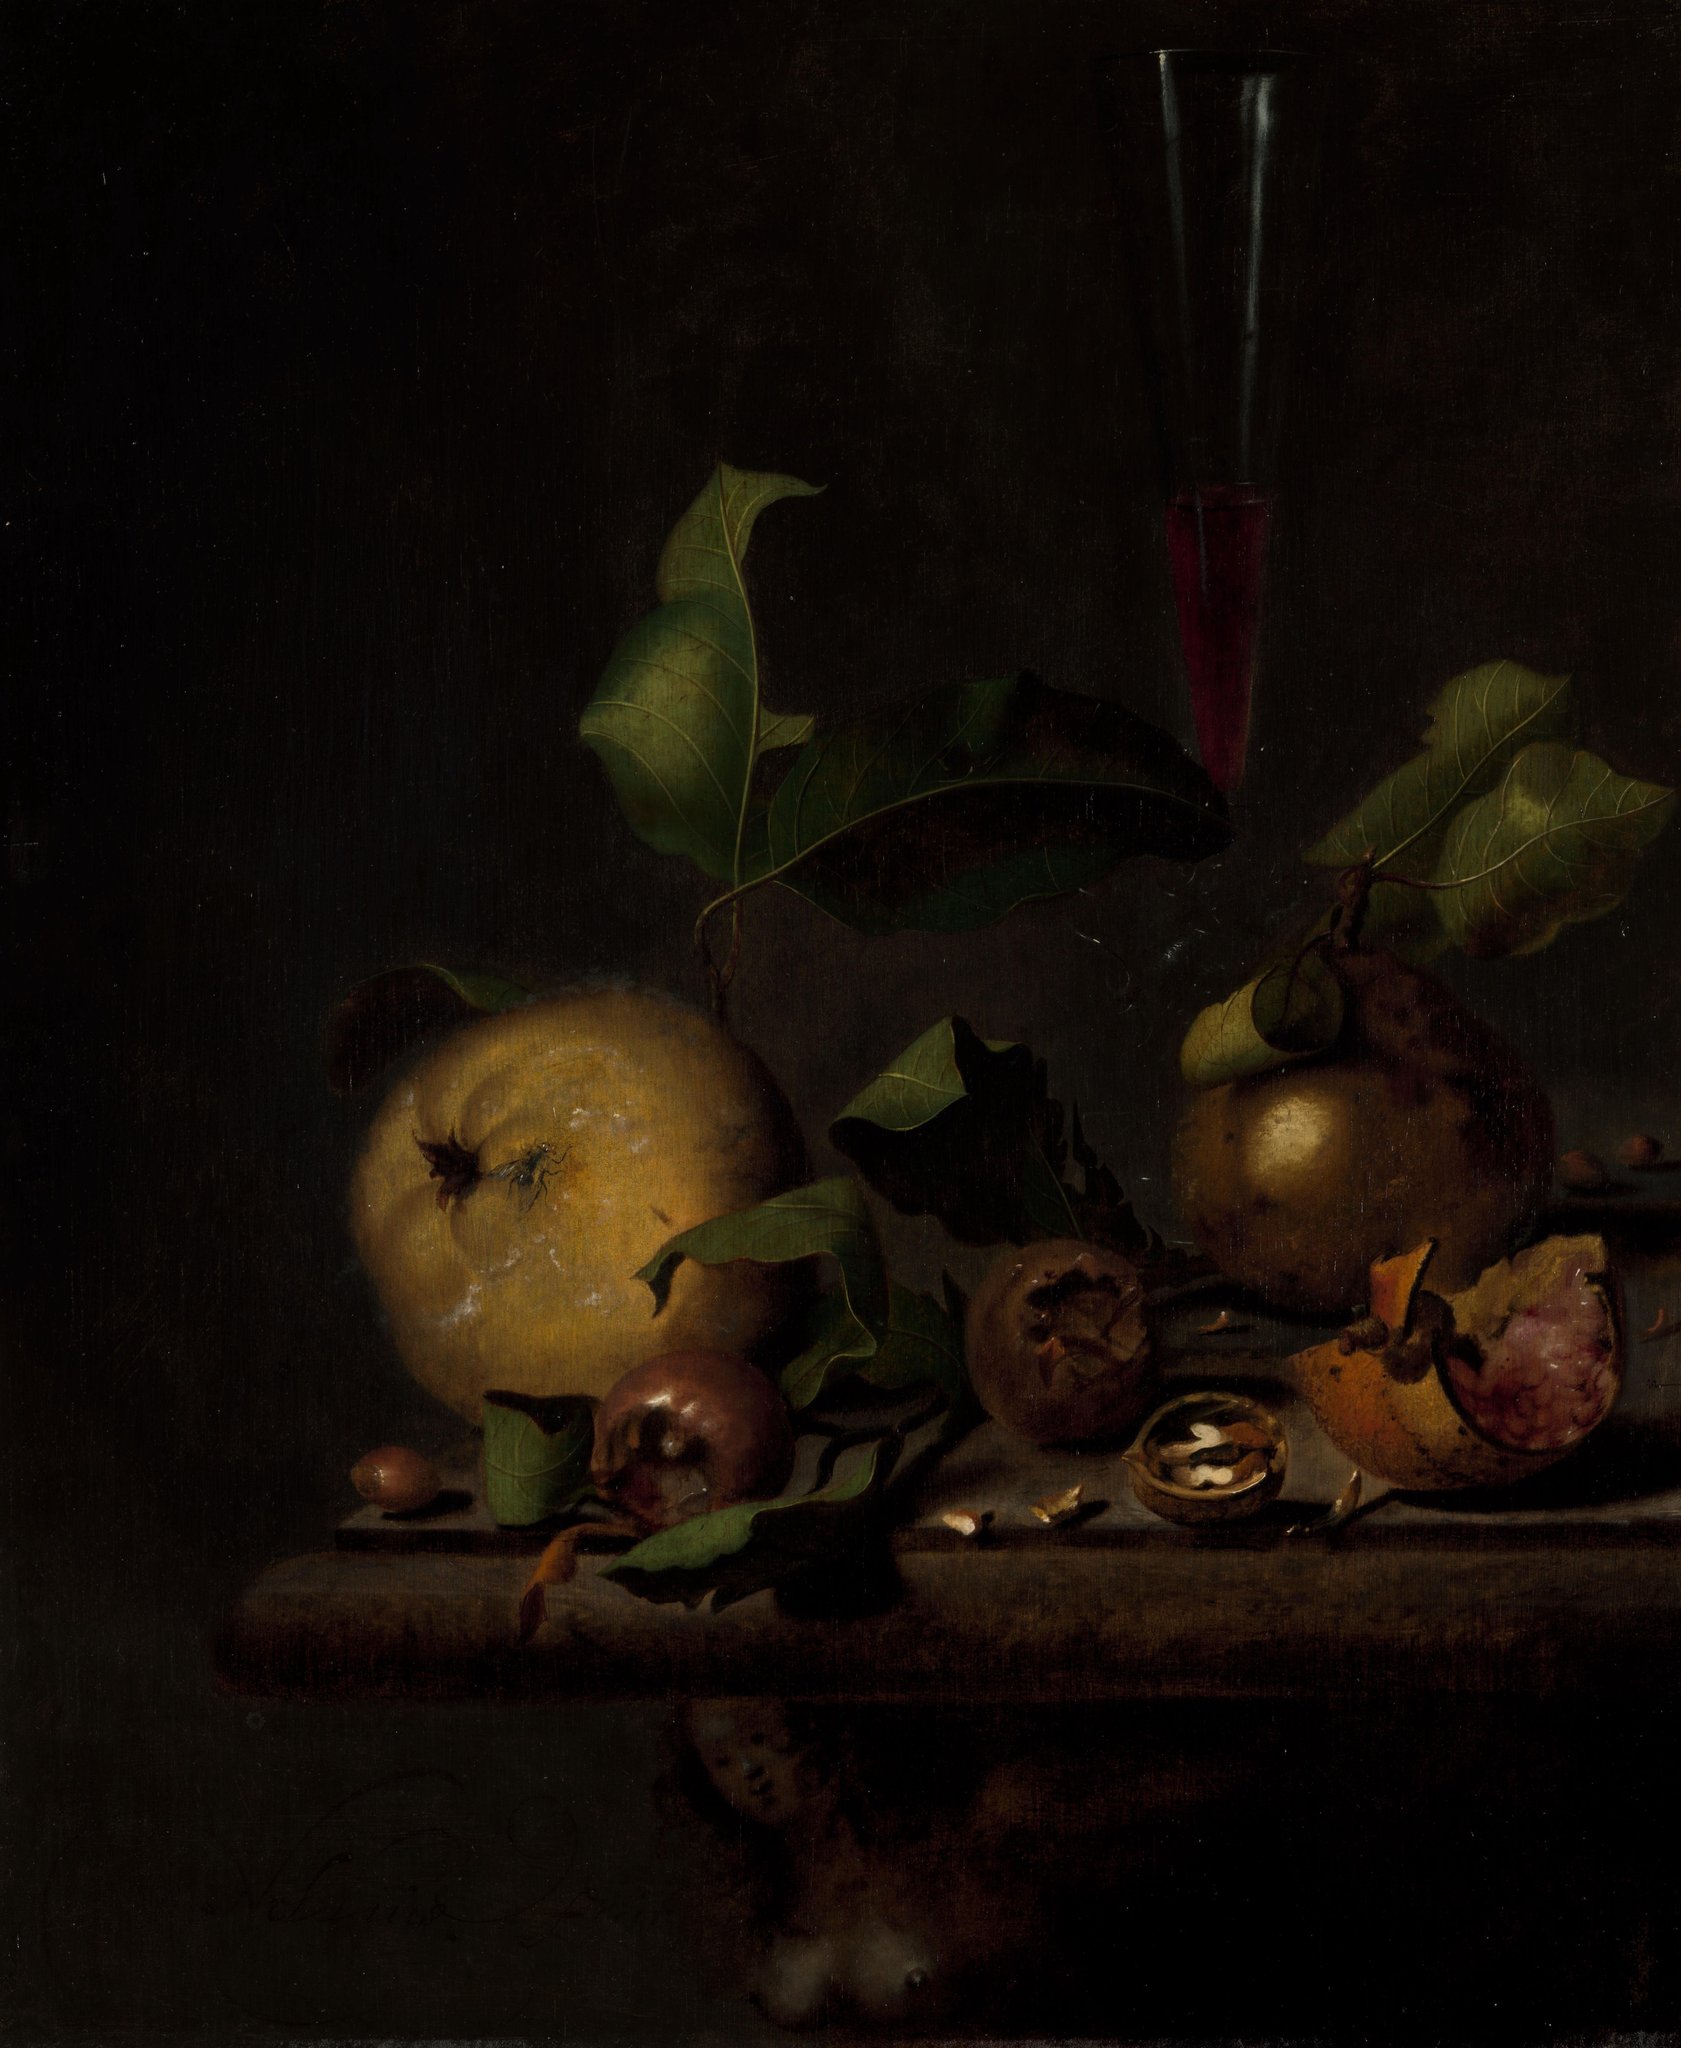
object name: painting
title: Still Life with Quinces, Medlars and a Glass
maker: martinus nellius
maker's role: painter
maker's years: 1674-1719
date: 1669-1719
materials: oil, panel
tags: fruits: pomegranate, fruits: medlar, fruits: pear, glass, rummer (flute), fruit, the (nude) human figure; 'corpo humano' (ripa) - aa - female human figure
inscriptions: signature: ‘Nellius fecit’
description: Virtually nothing is known about the painter Martinus Nellius, only a few works by whom have been preserved. He must have been active in Leiden and The Hague and, like his contemporary Adriaen Coorte, specialized in still lifes with simple compositions featuring only a few objects or fruits rendered with a great eye for detail.